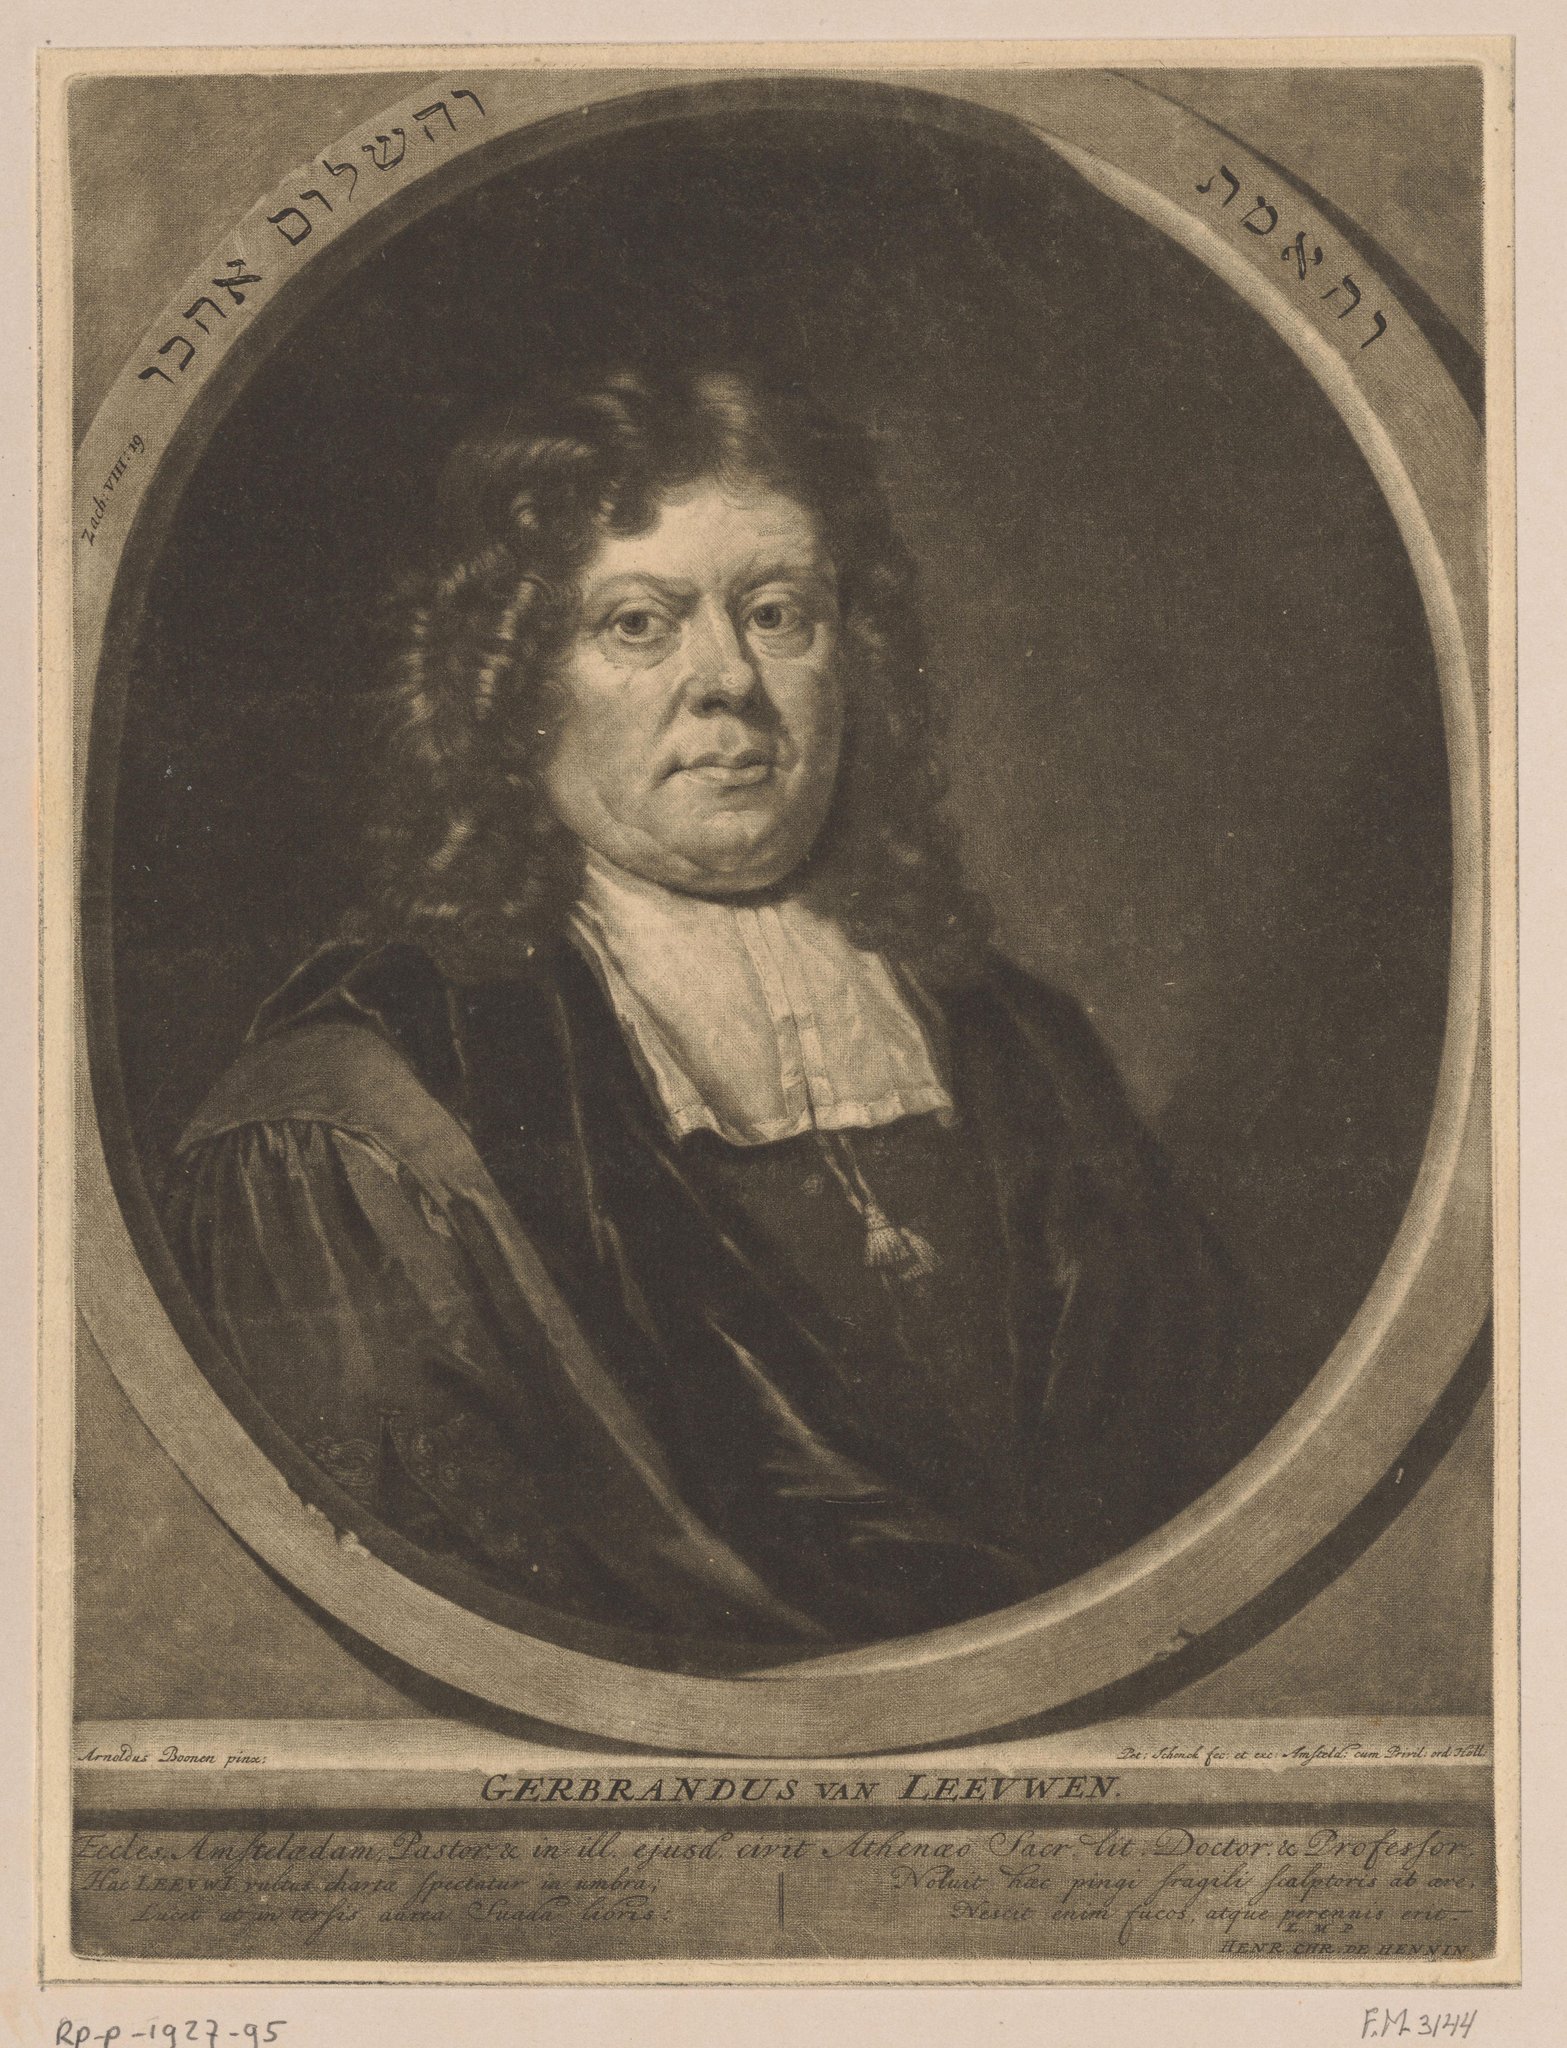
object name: print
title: Portret van Gerbrand van Leeuwen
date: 1695-1711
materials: paper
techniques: engraving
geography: amsterdam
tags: theologian, ornament ~ medallion, historical persons, professor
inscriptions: collector's mark: Lugt 2166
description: Met vierregelig vers in het Latijn in twee kolommen onder het portret.